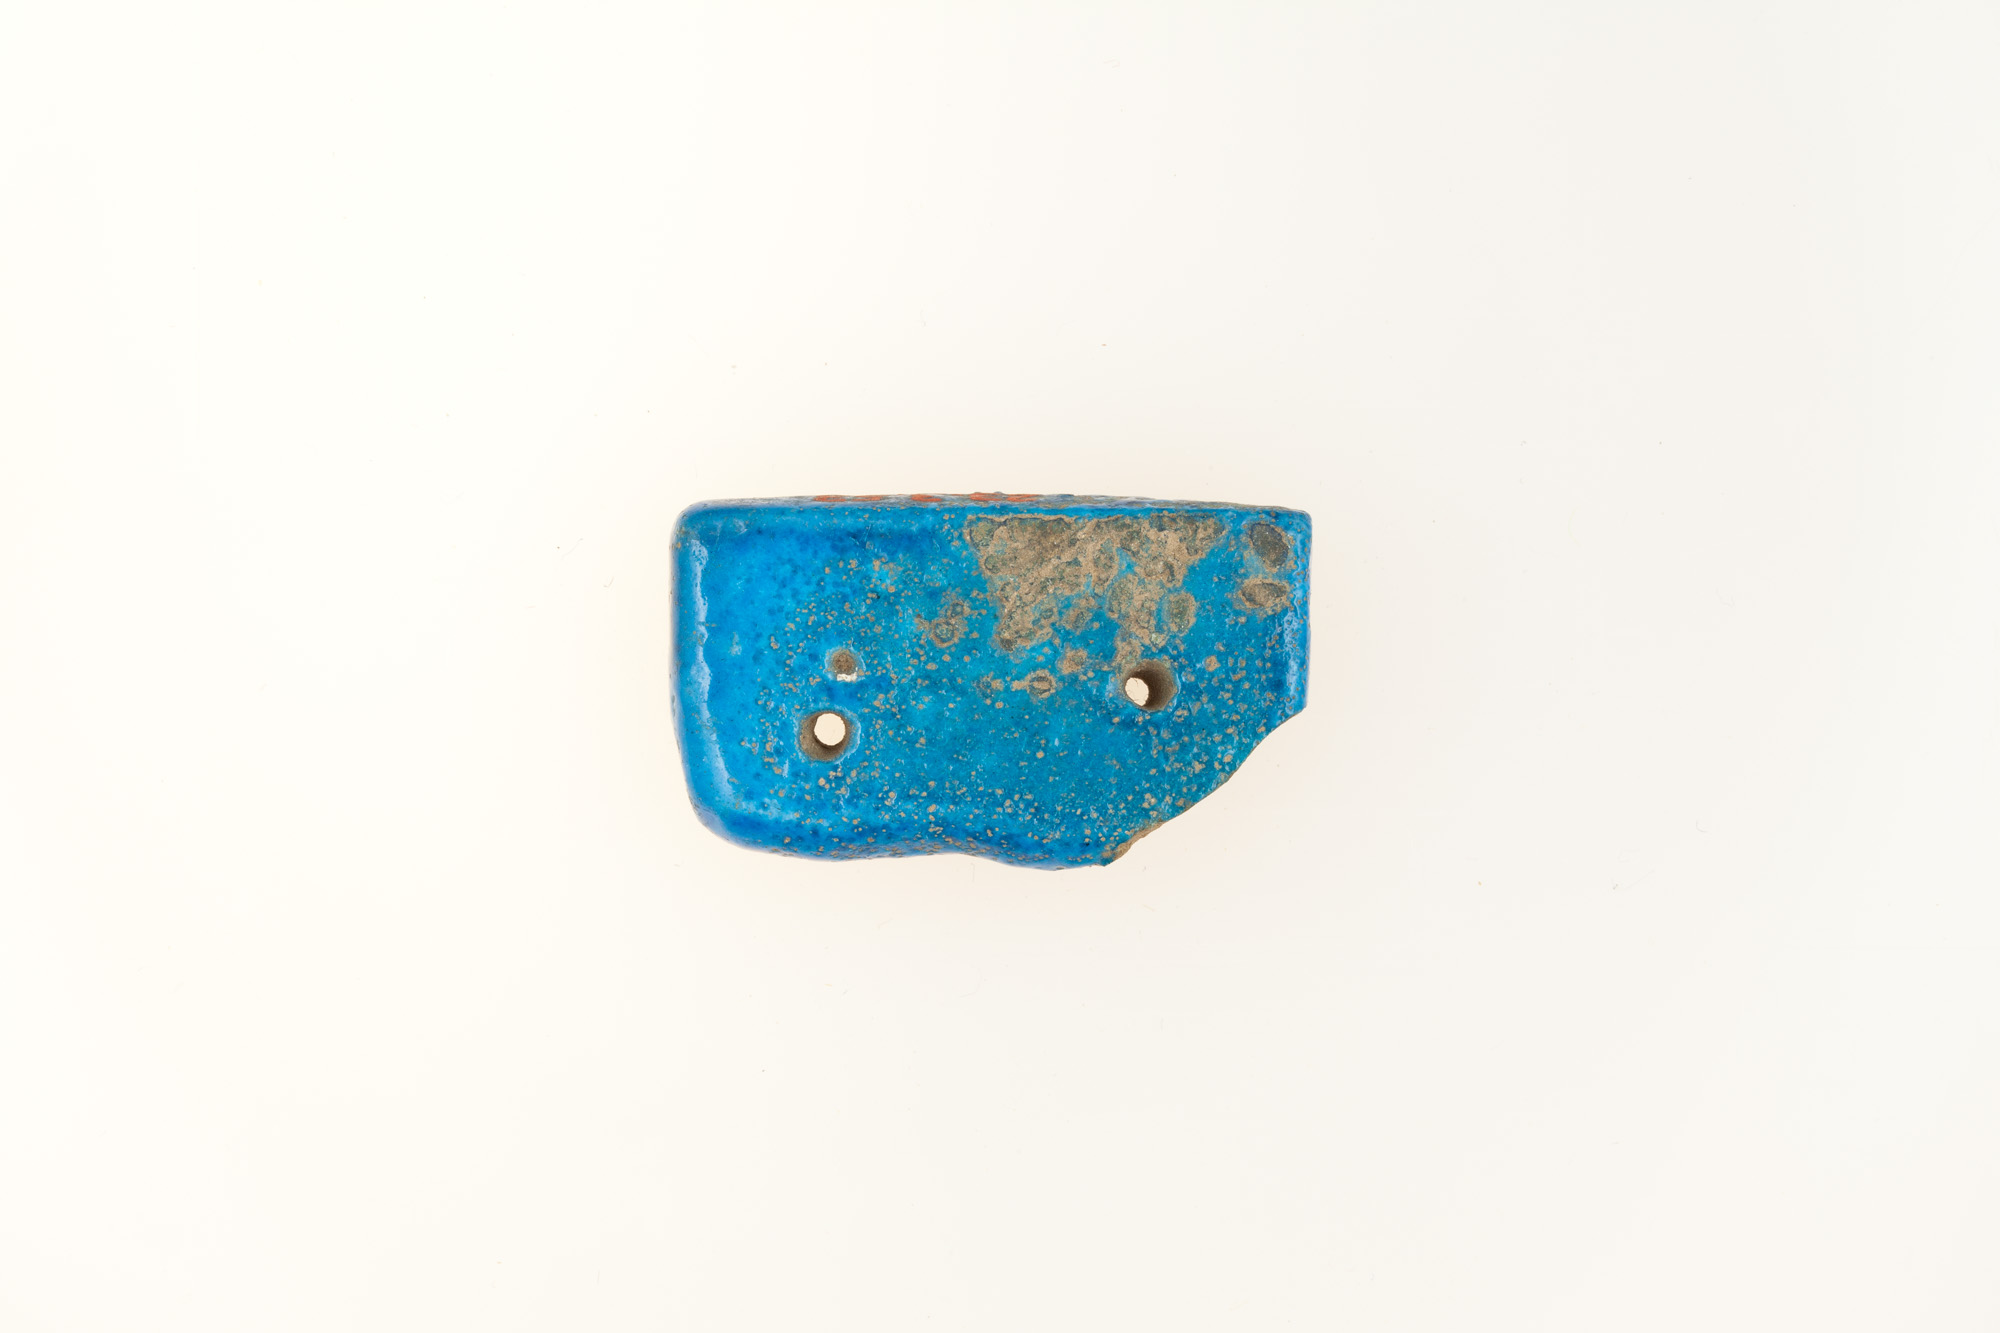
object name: menat fragment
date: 1479-1458 BCE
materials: faience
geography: egypt